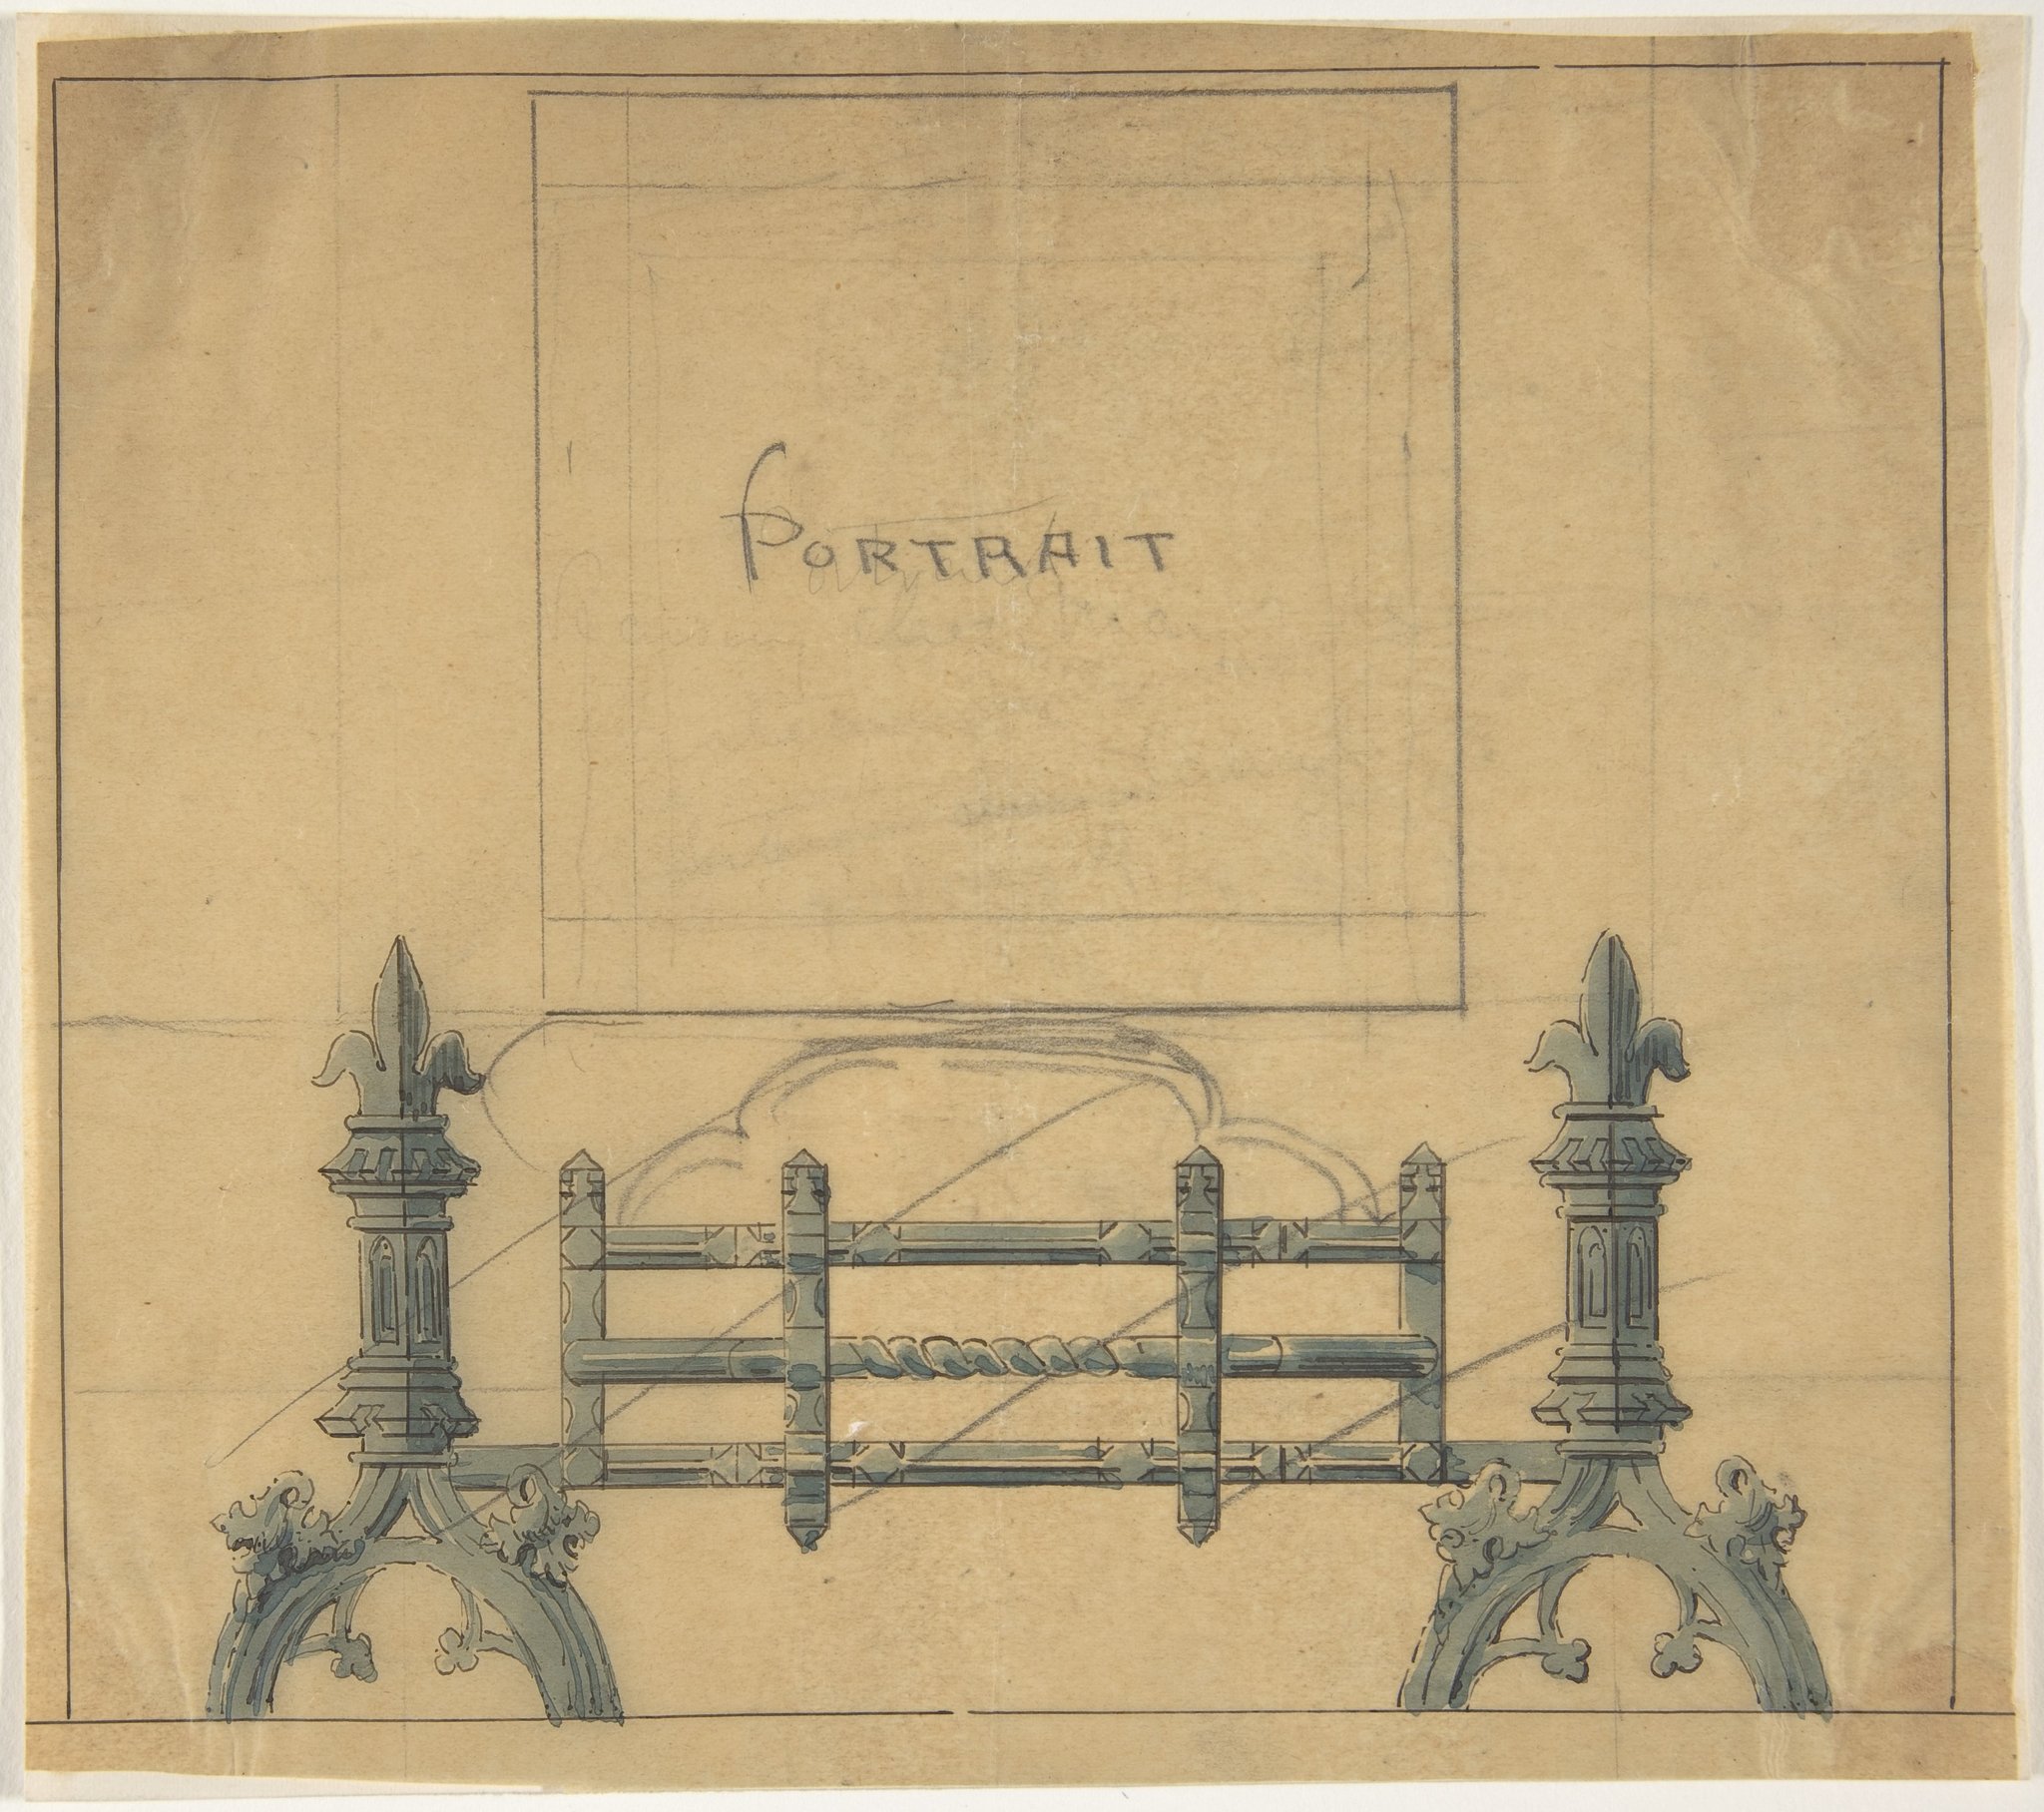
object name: drawing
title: Design for a Fireplace Grate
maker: anonymous, british, 19th century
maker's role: artist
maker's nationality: british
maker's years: 1800-1900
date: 1801-1900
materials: graphite, ink, watercolor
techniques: pen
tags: fireplaces